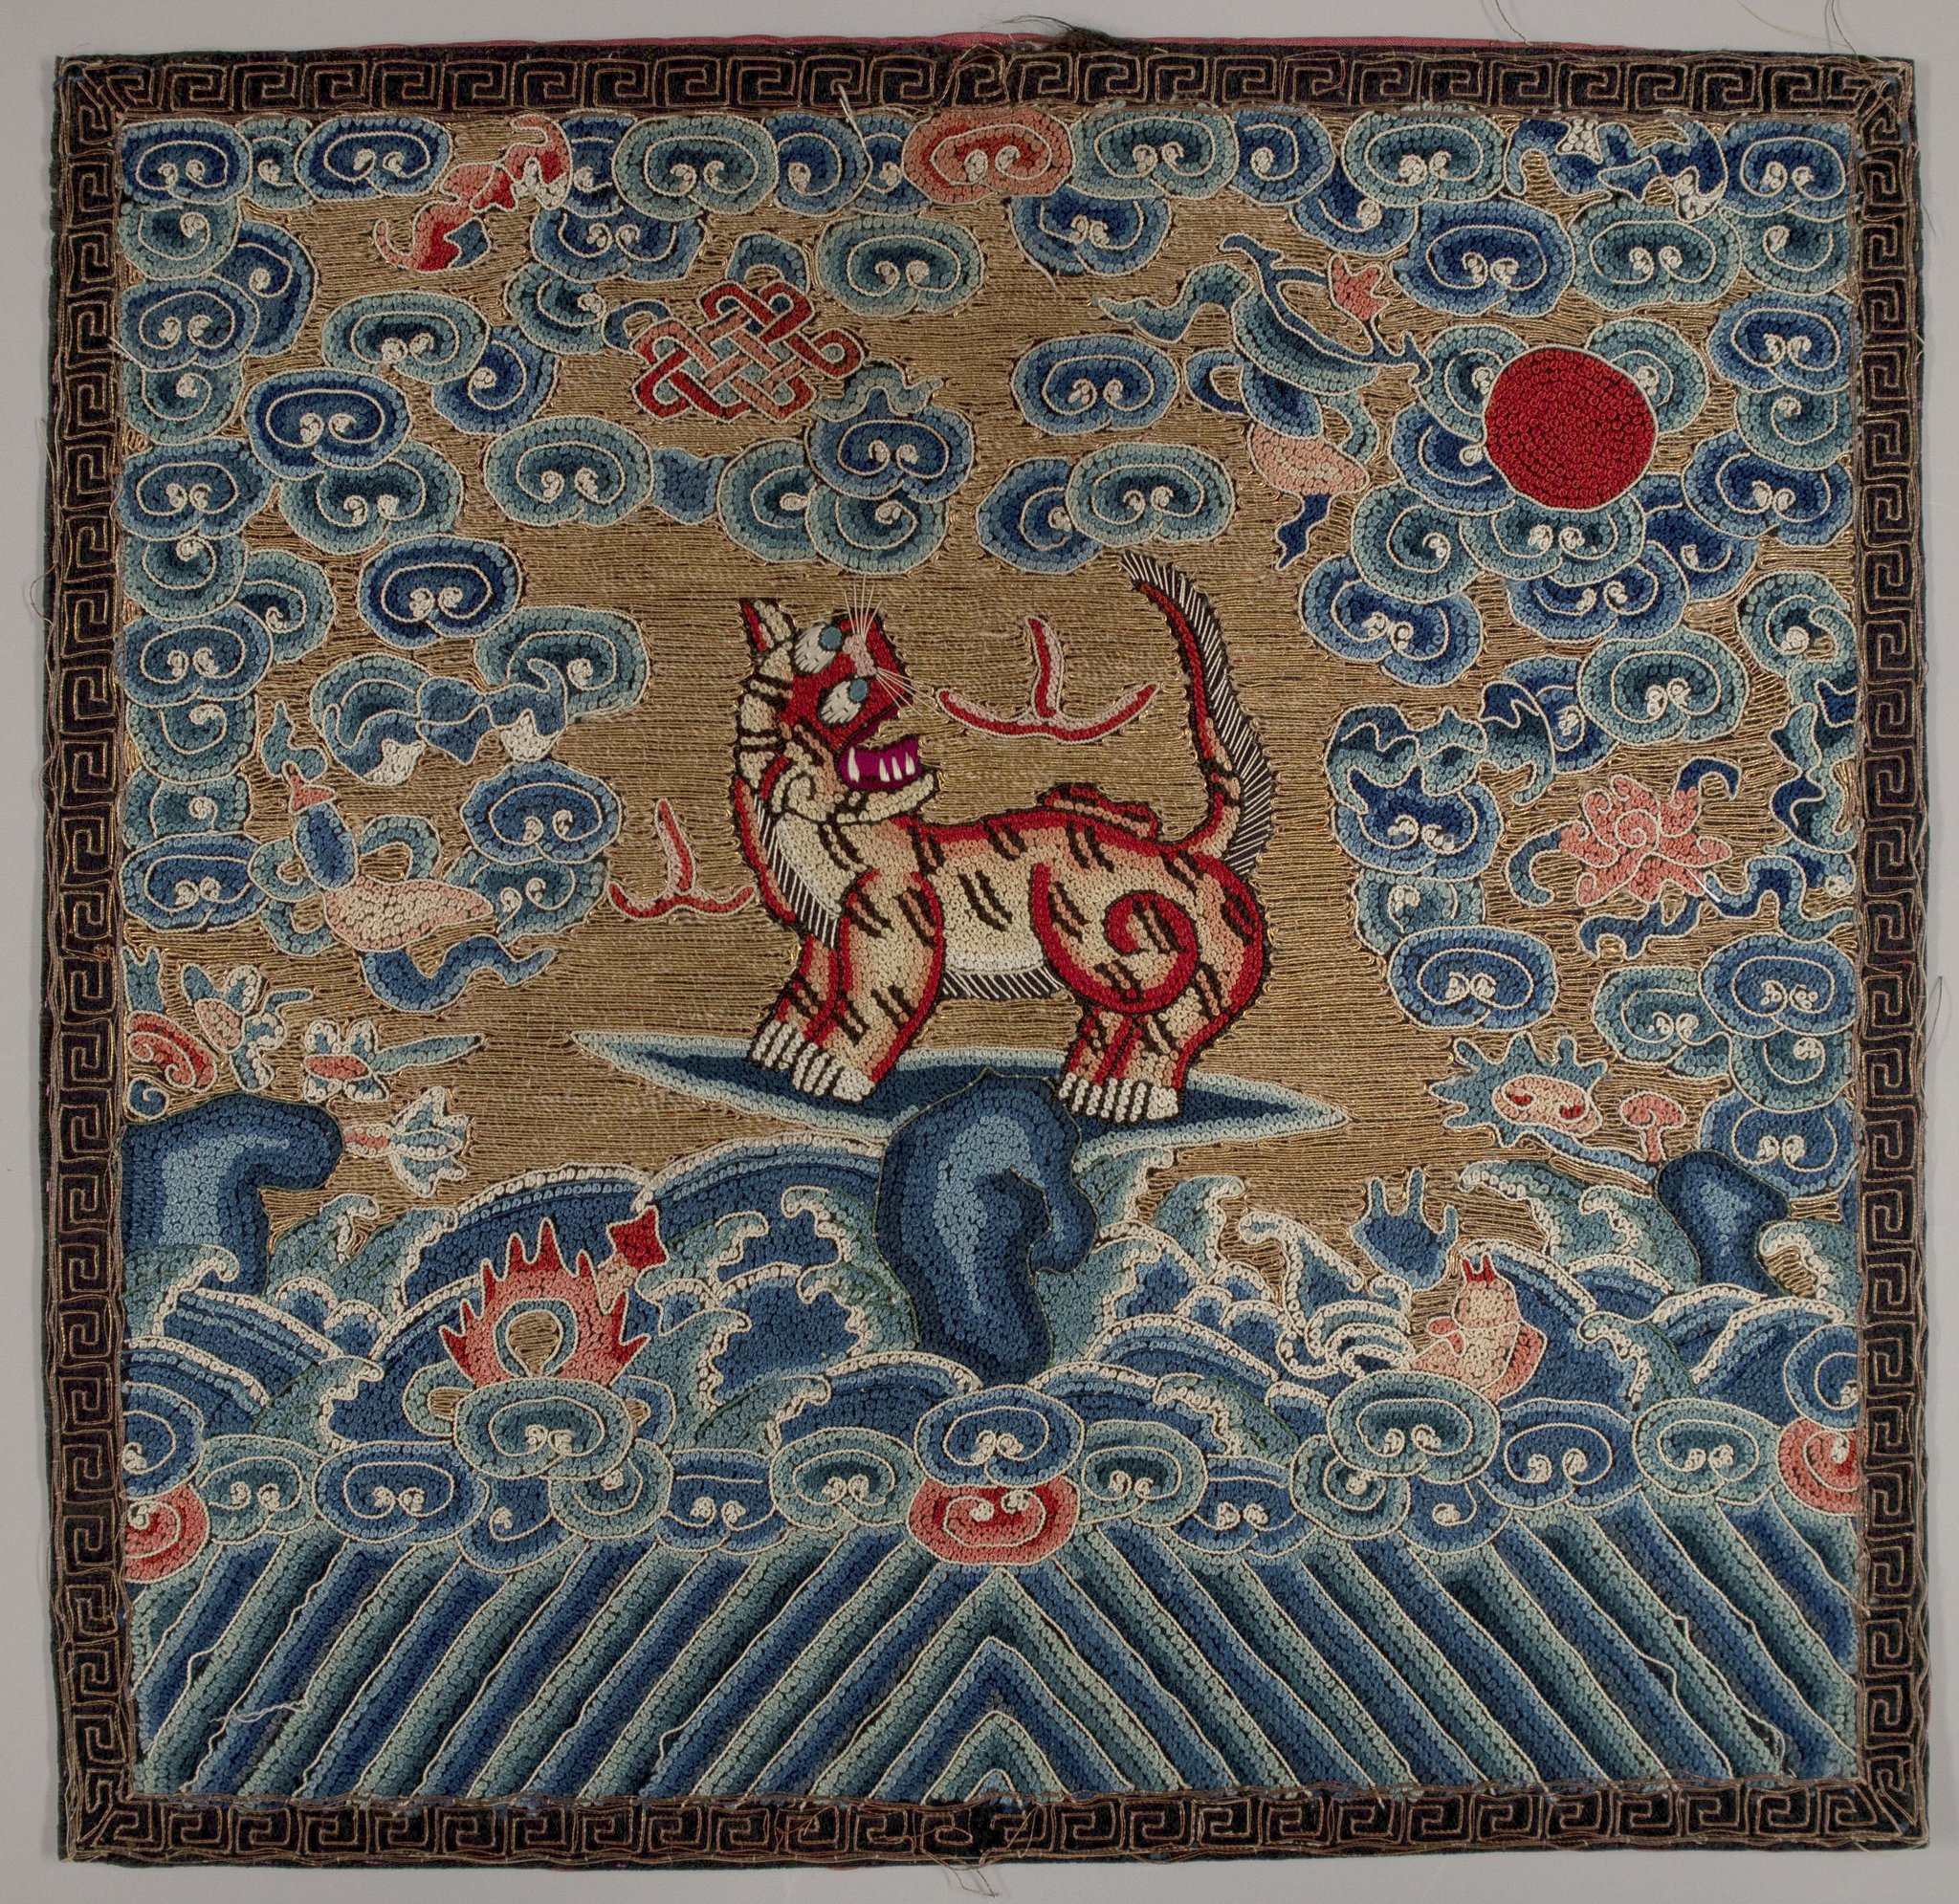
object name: rank badge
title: Rank badge with tiger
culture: chinese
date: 1701-1900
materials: metal thread, silk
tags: tigers